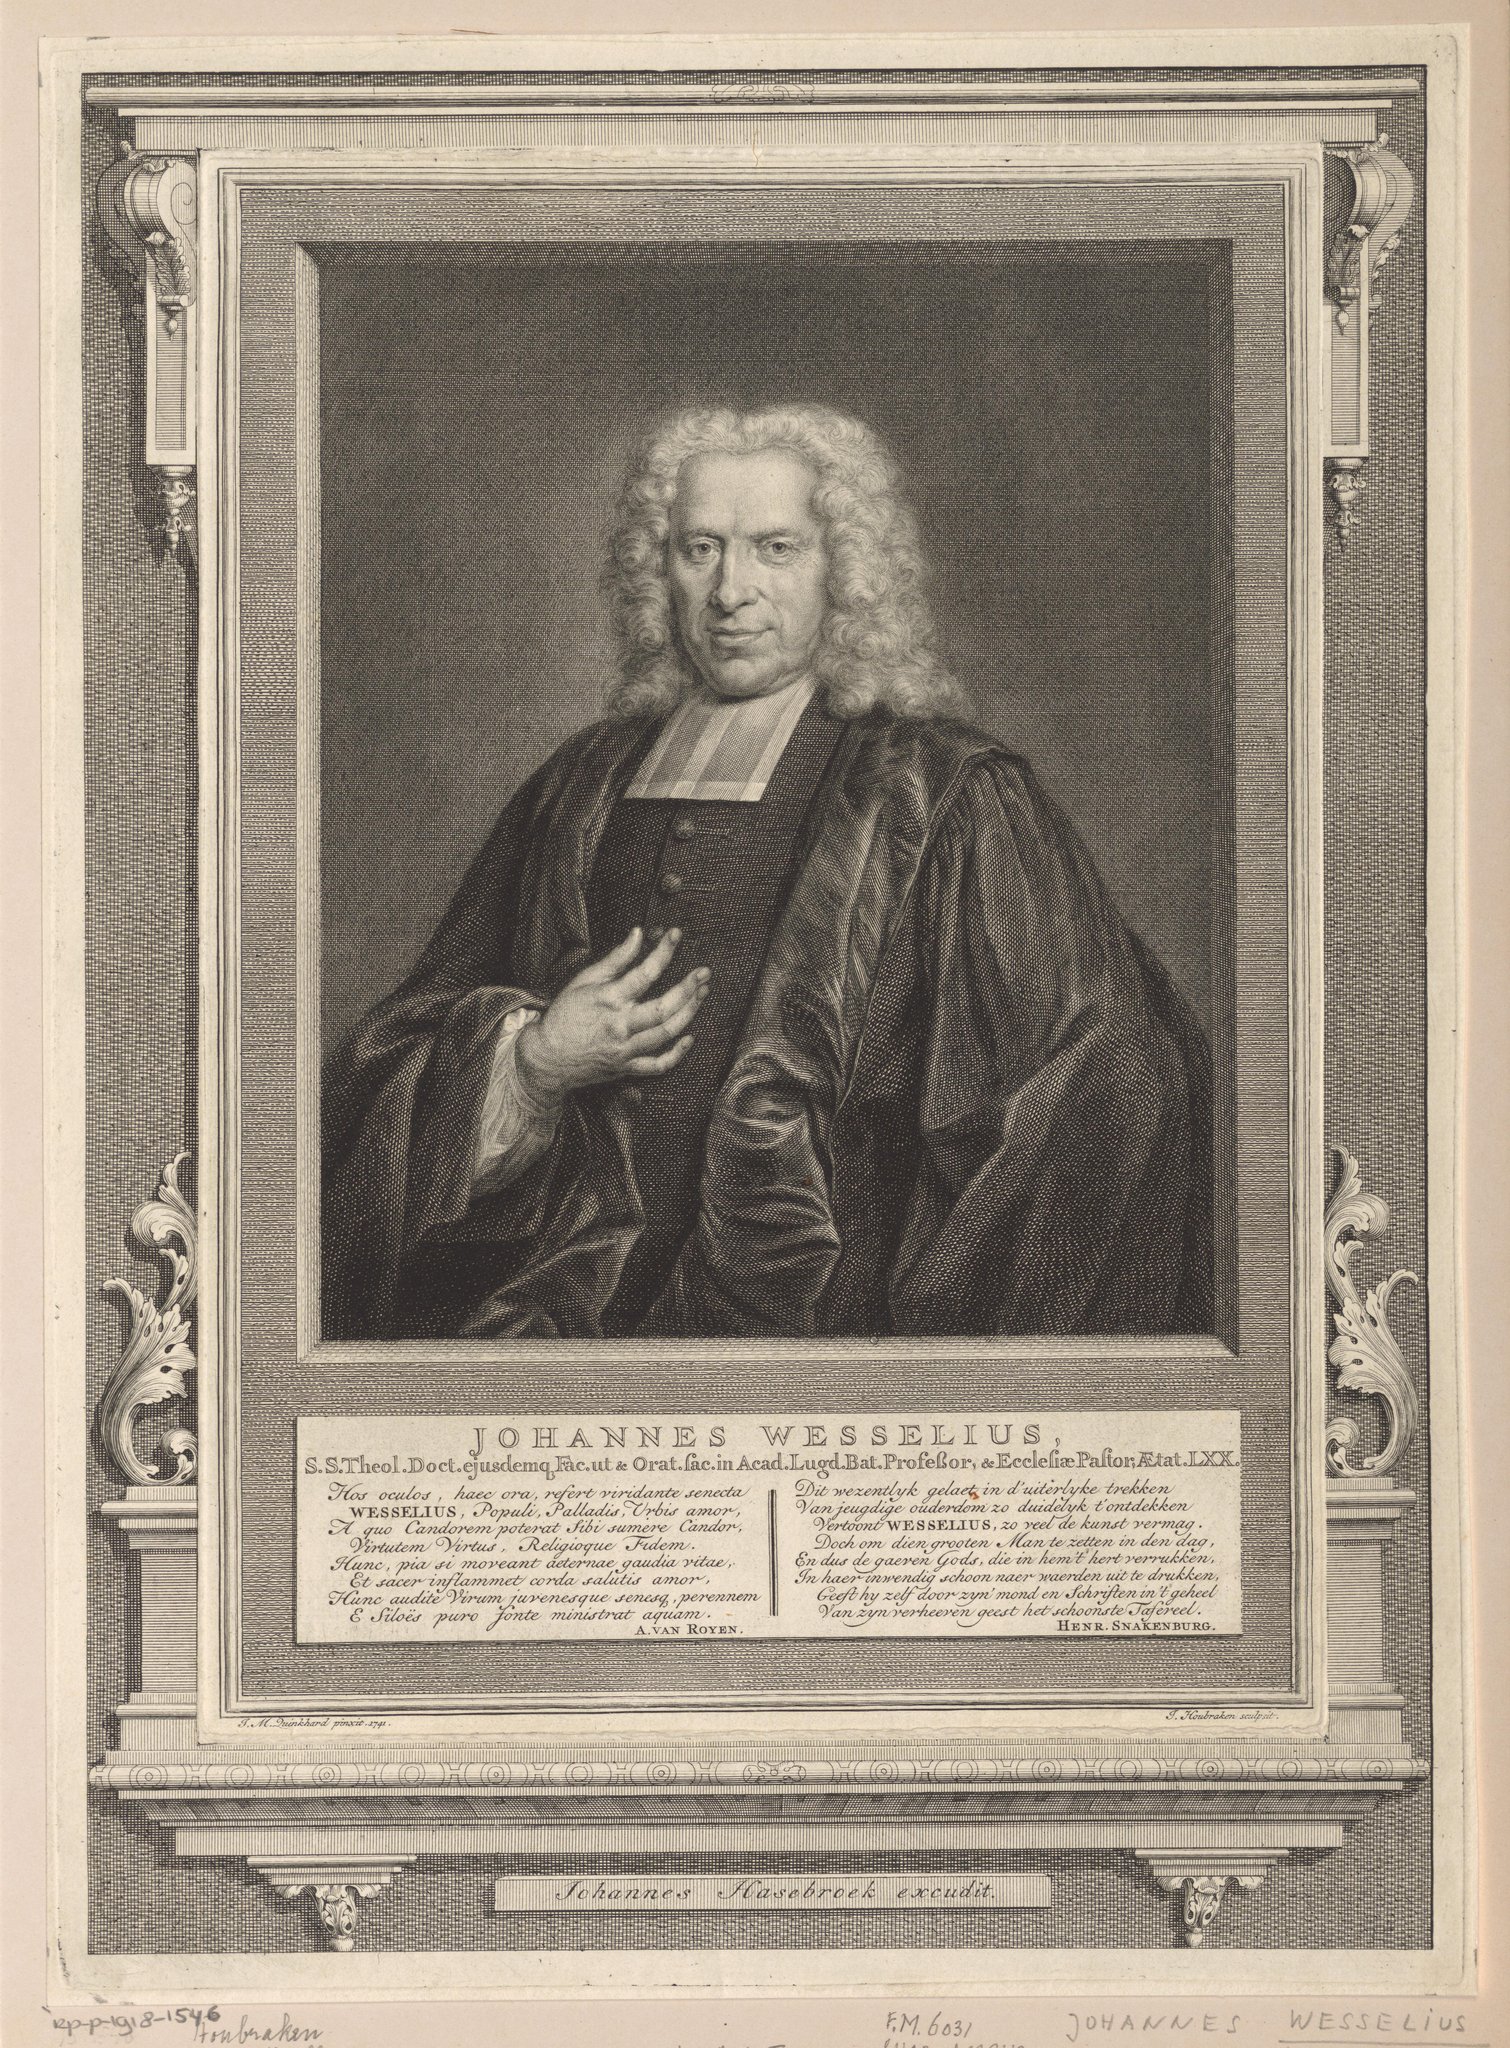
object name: print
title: Portret van Johannes Wesselius op 70-jarige leeftijd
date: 1741-1780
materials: paper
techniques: engraving, etching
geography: leiden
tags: leiden, theologian, historical persons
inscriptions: collector's mark: Lugt 2233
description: Onder het portret een achtregelig vers in het Latijn en een achtregelig vers in het Nederlands, in twee kolommen.